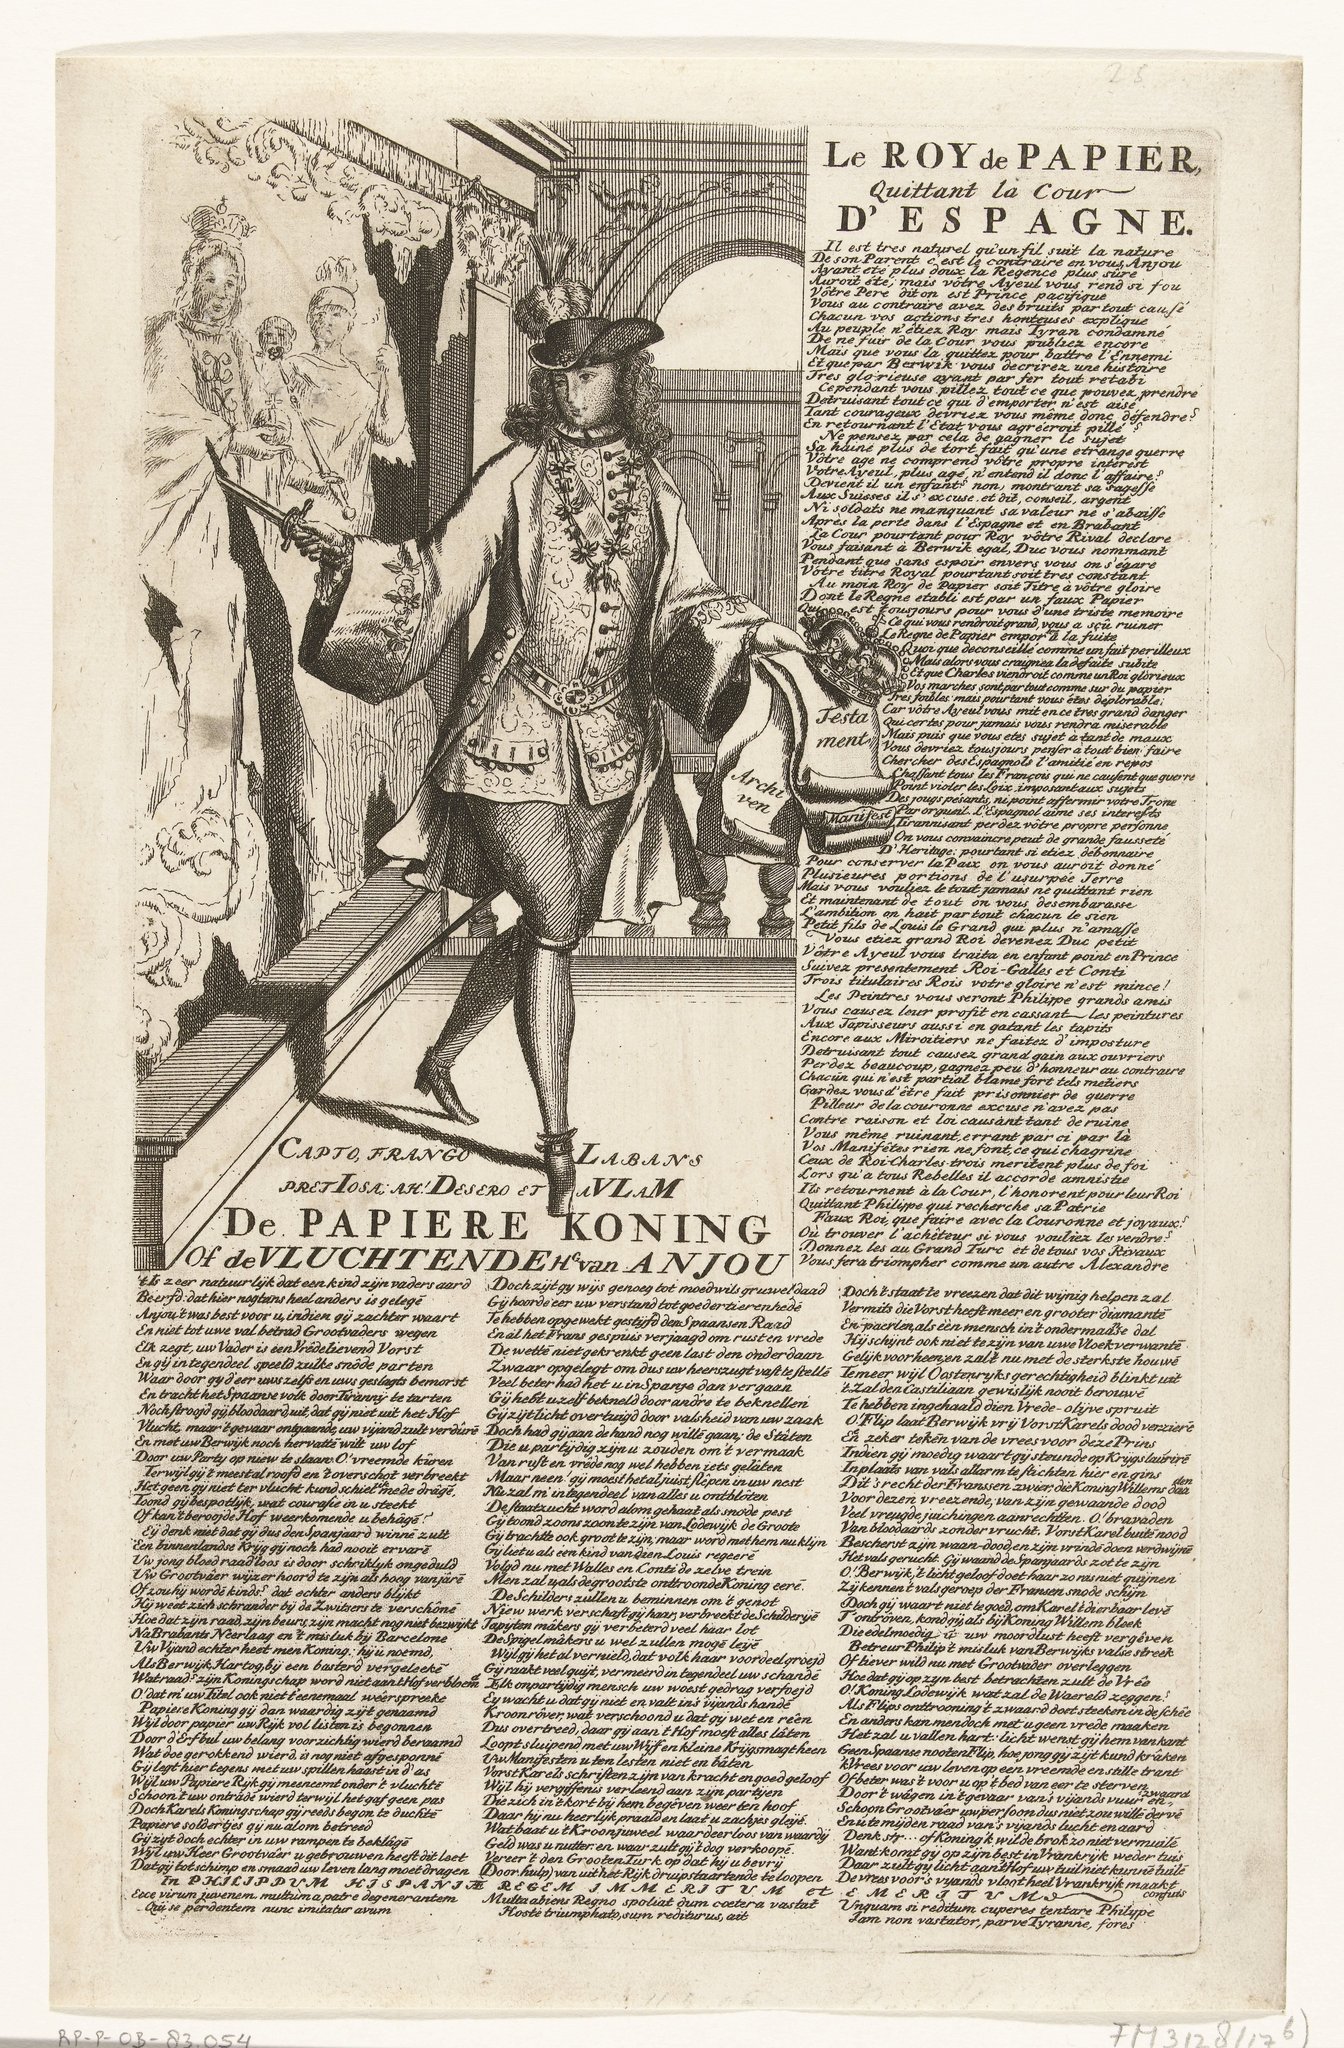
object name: cartoon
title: De Papiere Koning Of de vluchtende Hg. van Anjou / Le Roy de Papier, Quittant la Cour D'Espagne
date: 1706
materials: paper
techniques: etching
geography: amsterdam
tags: filips v (koning van spanje), art (+ work of art damaged by iconoclasm), political caricatures and satires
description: Filips V, hertog van Anjou, koning van Spanje alleen op papier, vlucht uit het Spaanse Koninklijk Paleis met meeneming van de kroon, 1706. Met zijn dolk vernielt hij een wandtapijt. In de plaat verzen in het Nederlands en Frans. Spotprent op de situatie in het jaar 1706 in de Spaanse Successieoorlog. Onderdeel van een reeks van 25 spotprenten op de Fransen en bondgenoten uit het jaar 1706.